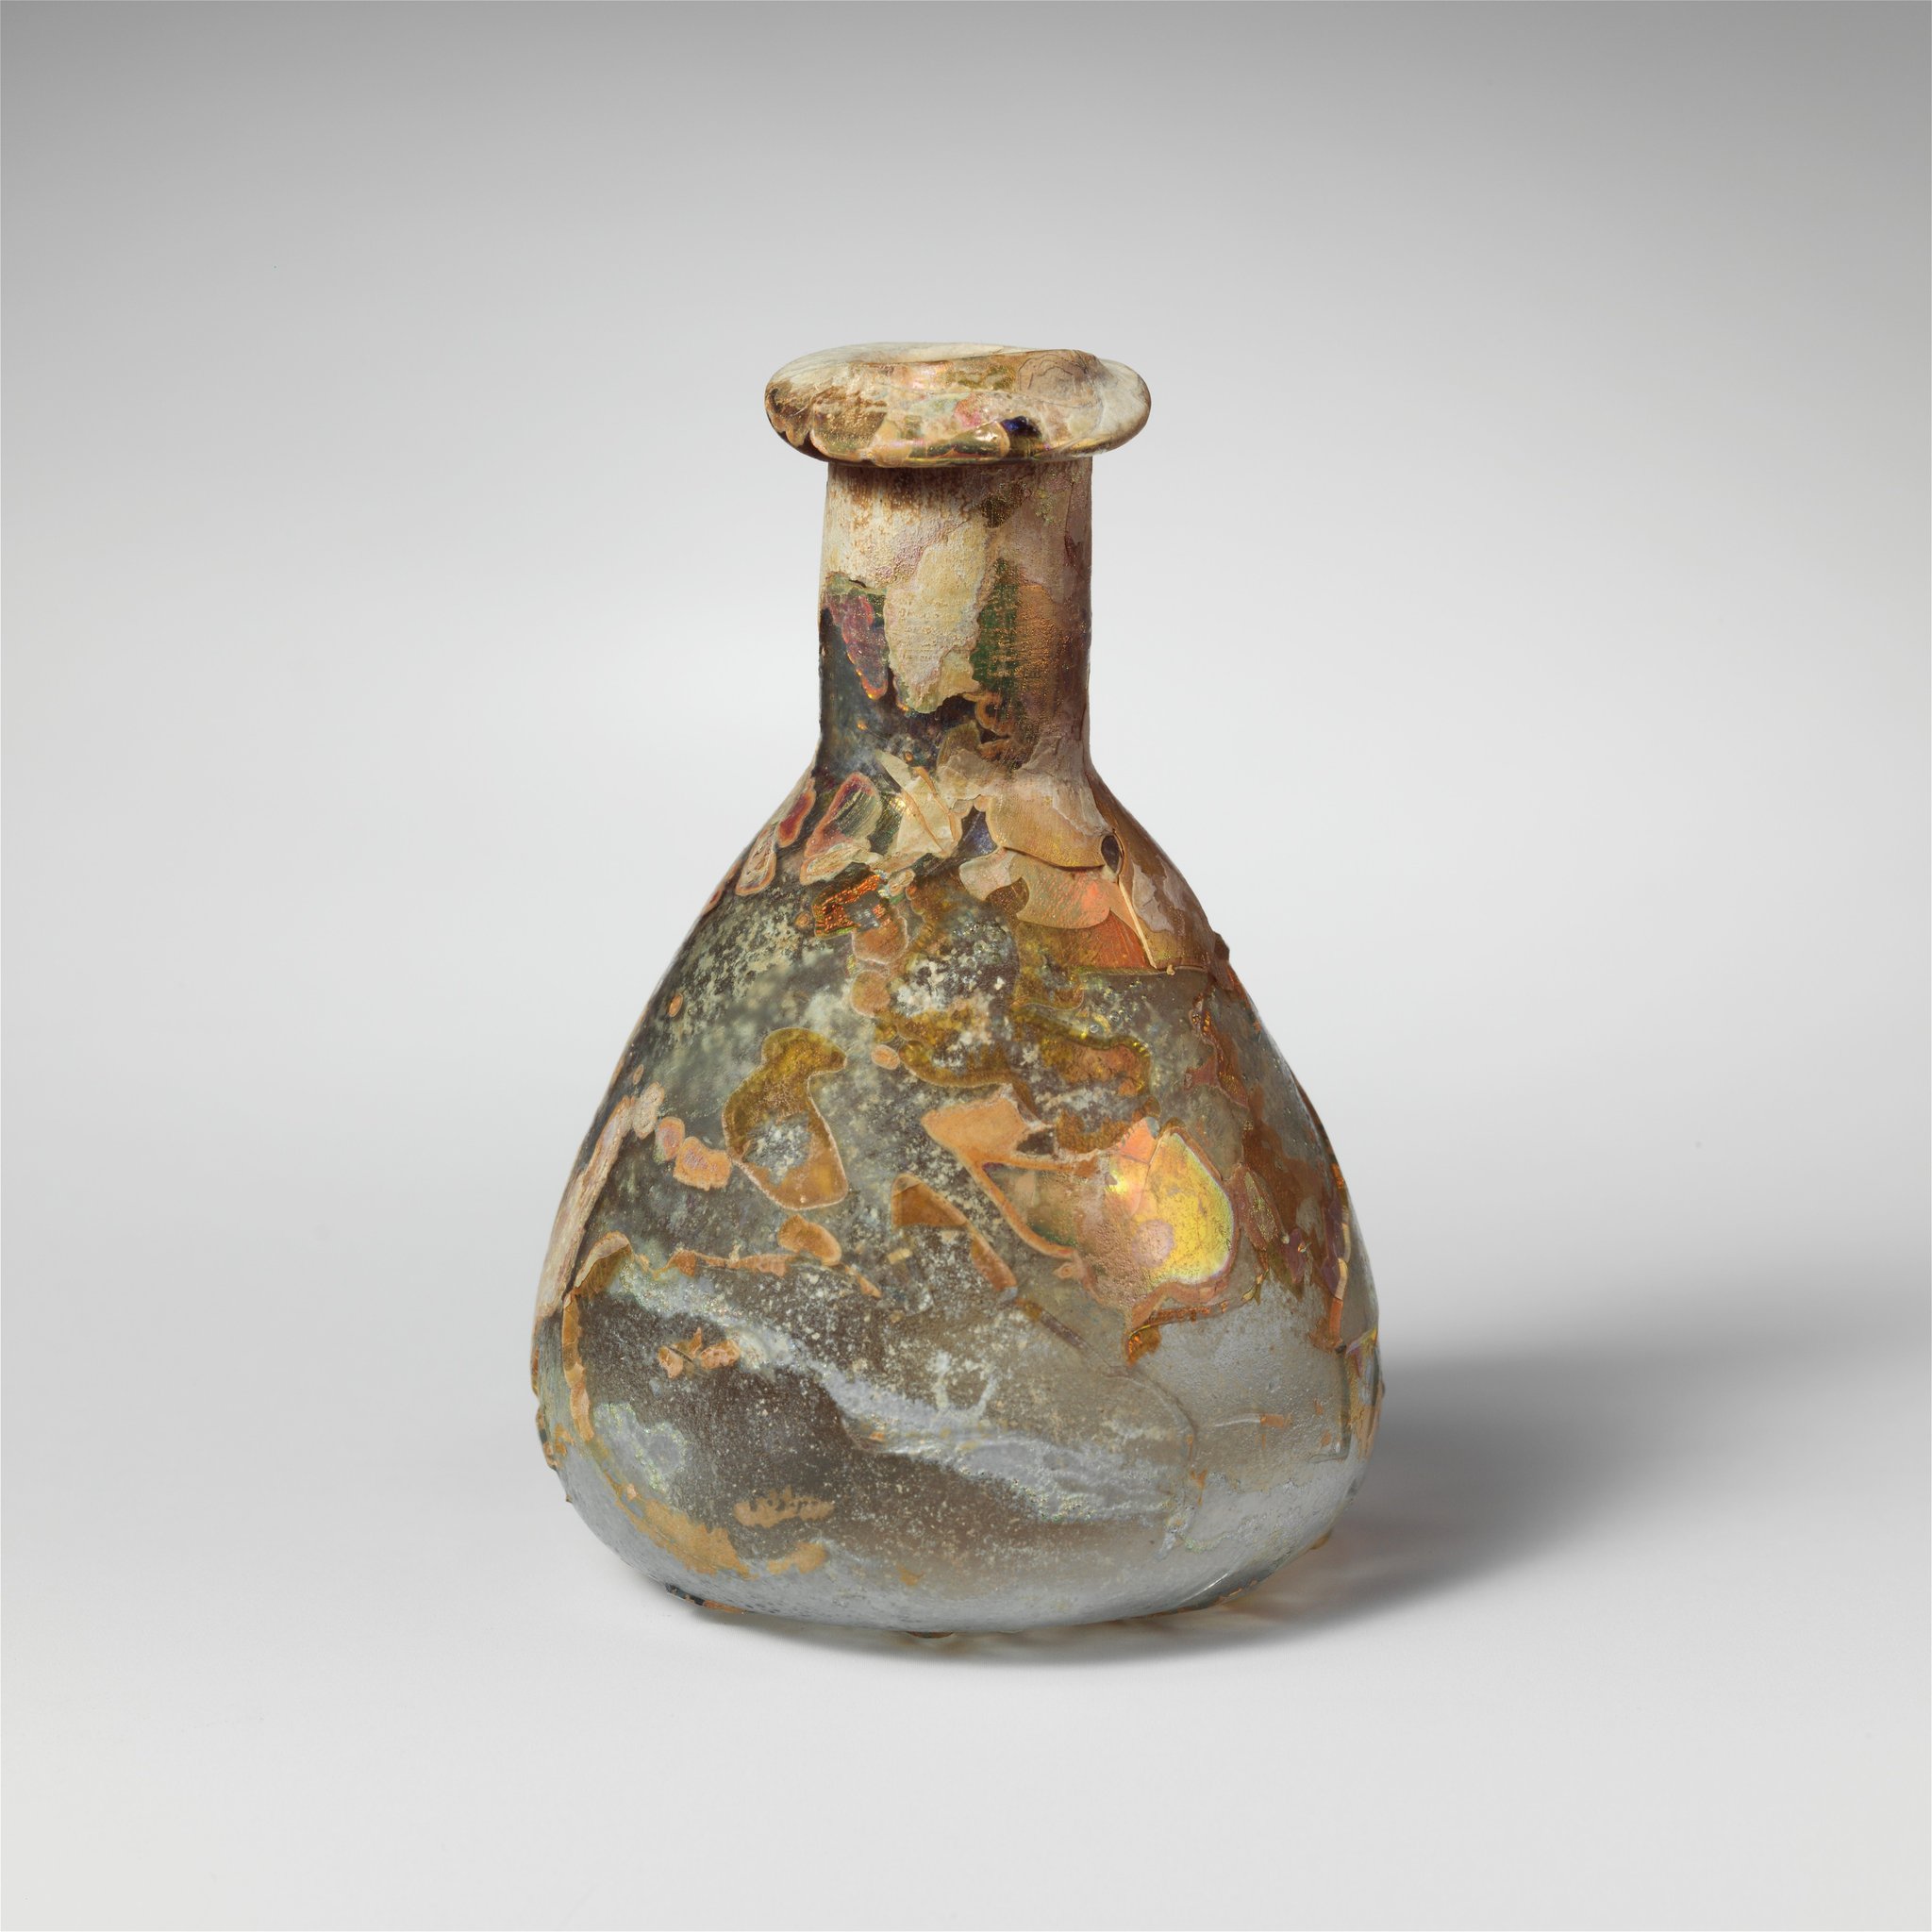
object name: perfume bottle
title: Glass perfume bottle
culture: roman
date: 1-100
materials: glass